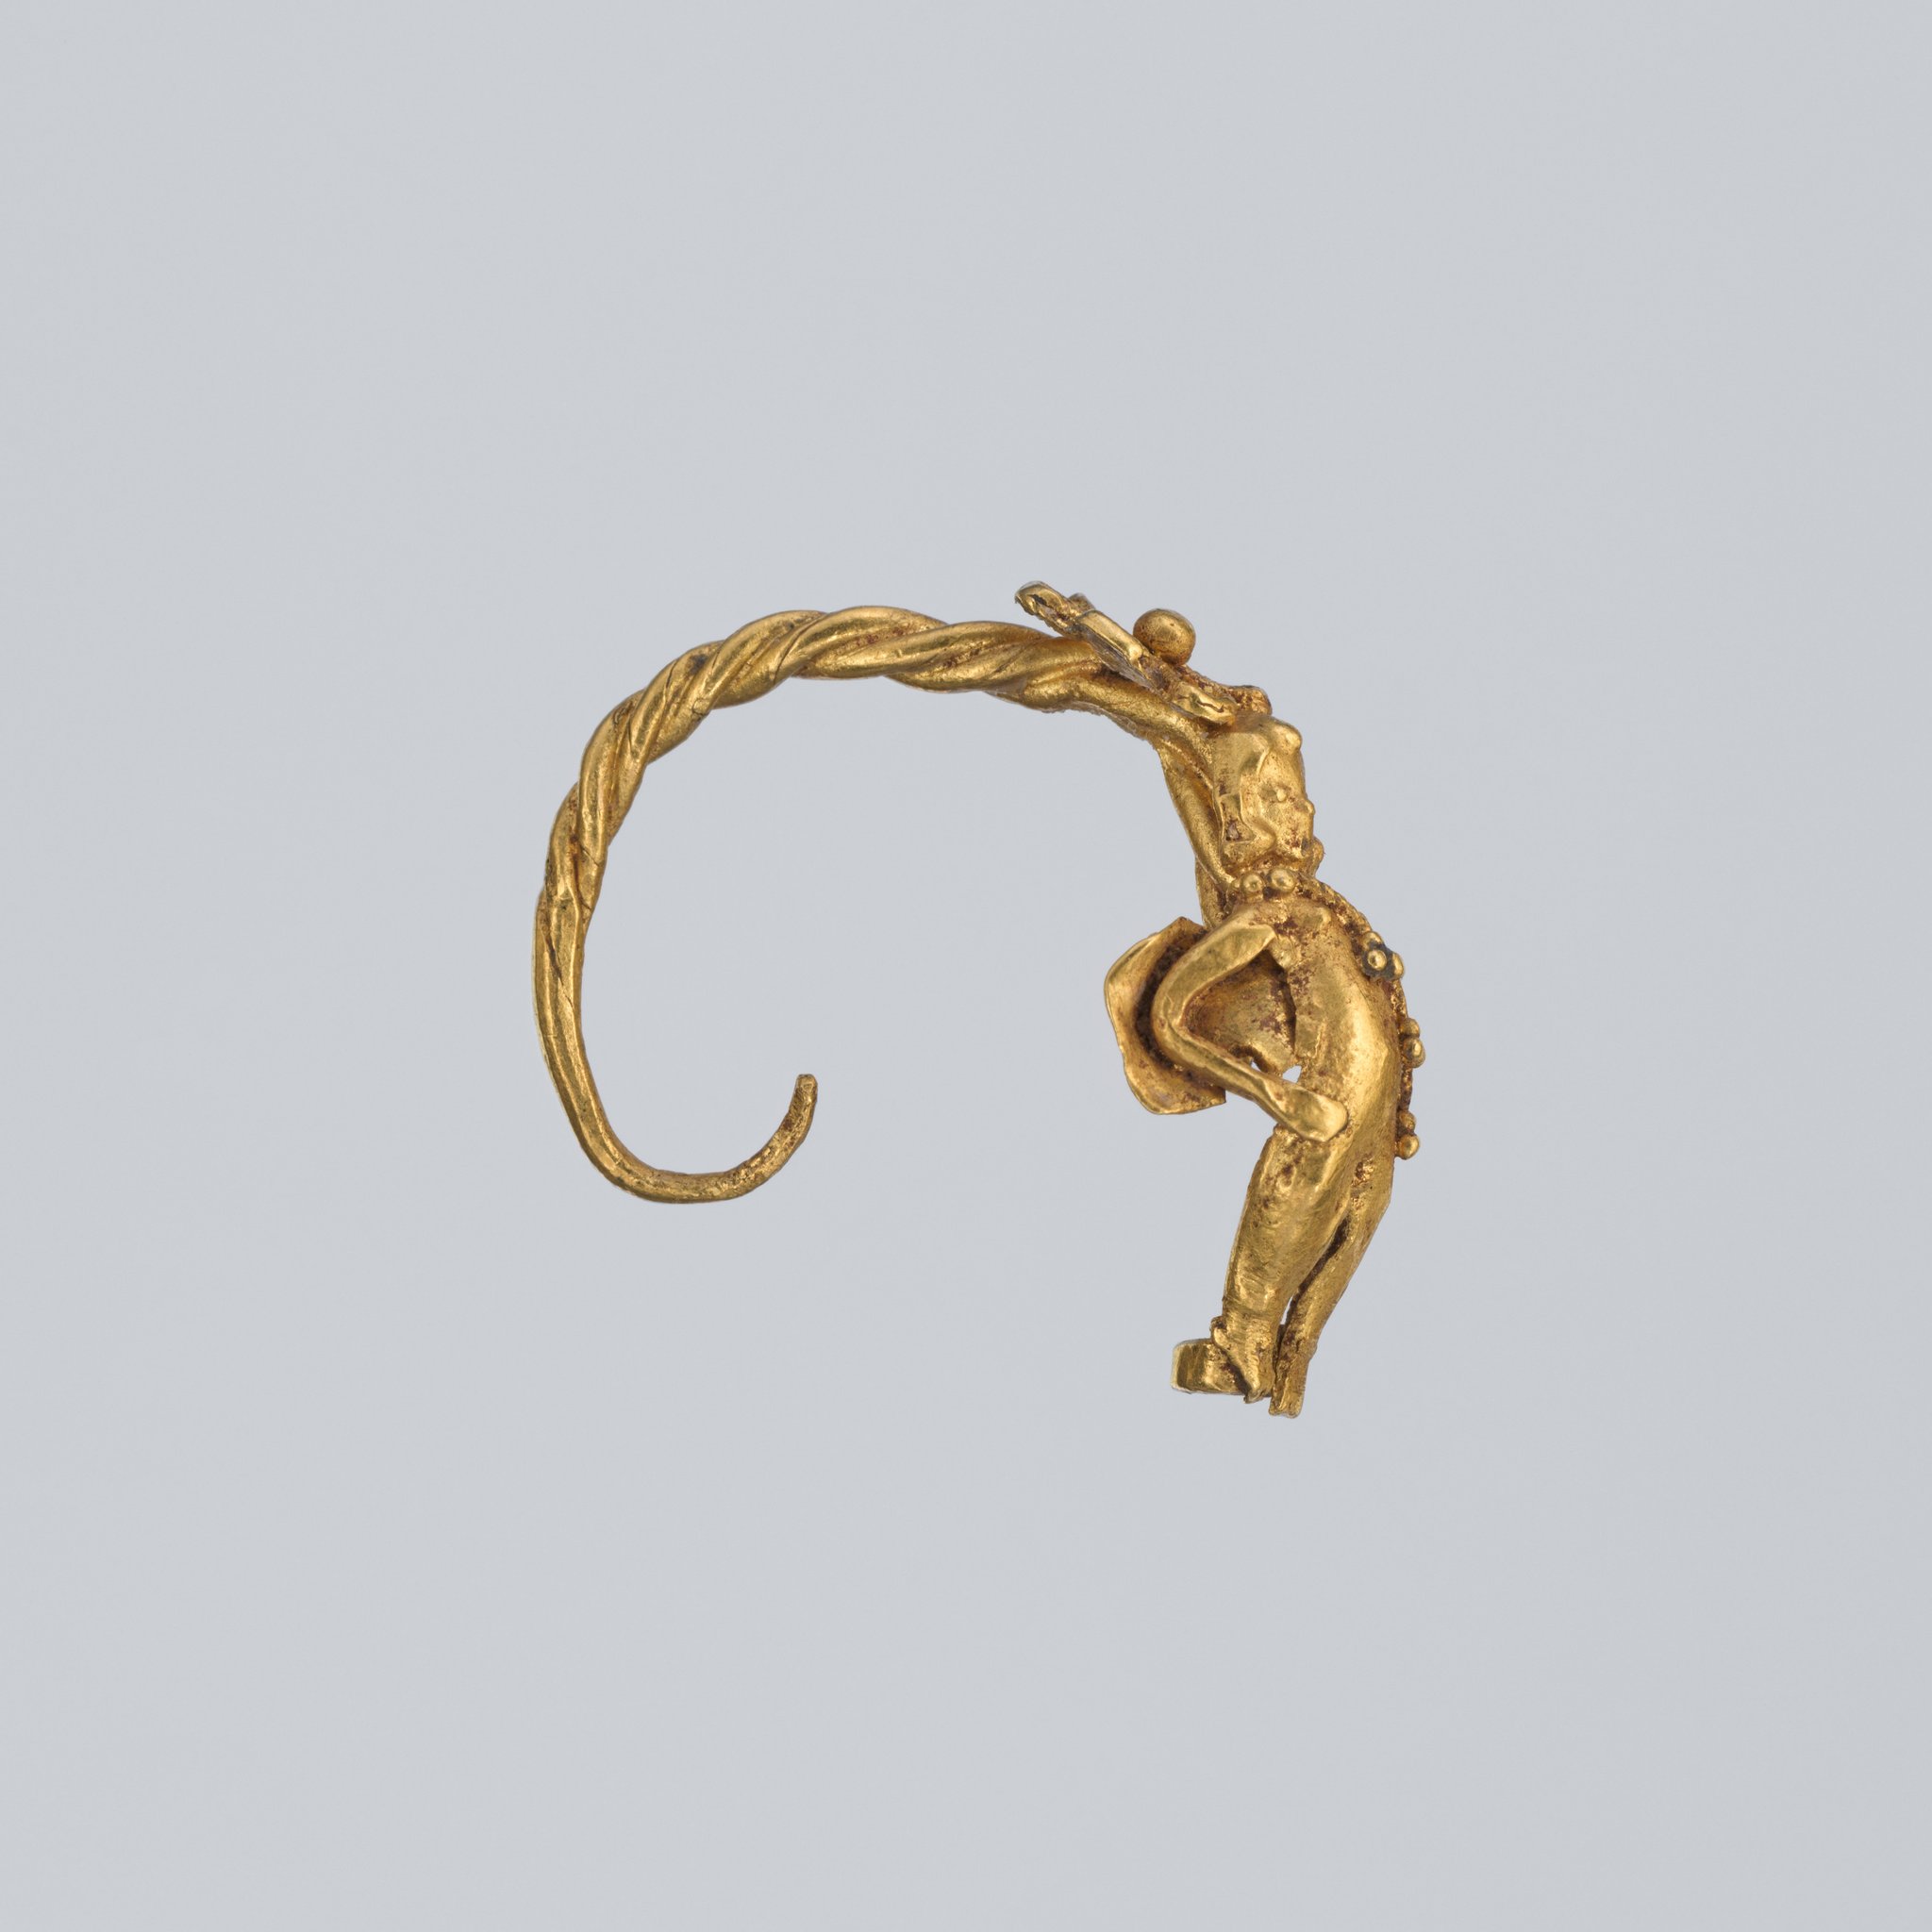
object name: earring with eros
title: Gold earring with winged figure (one of a pair)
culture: greek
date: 100-1 BCE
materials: gold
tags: eros